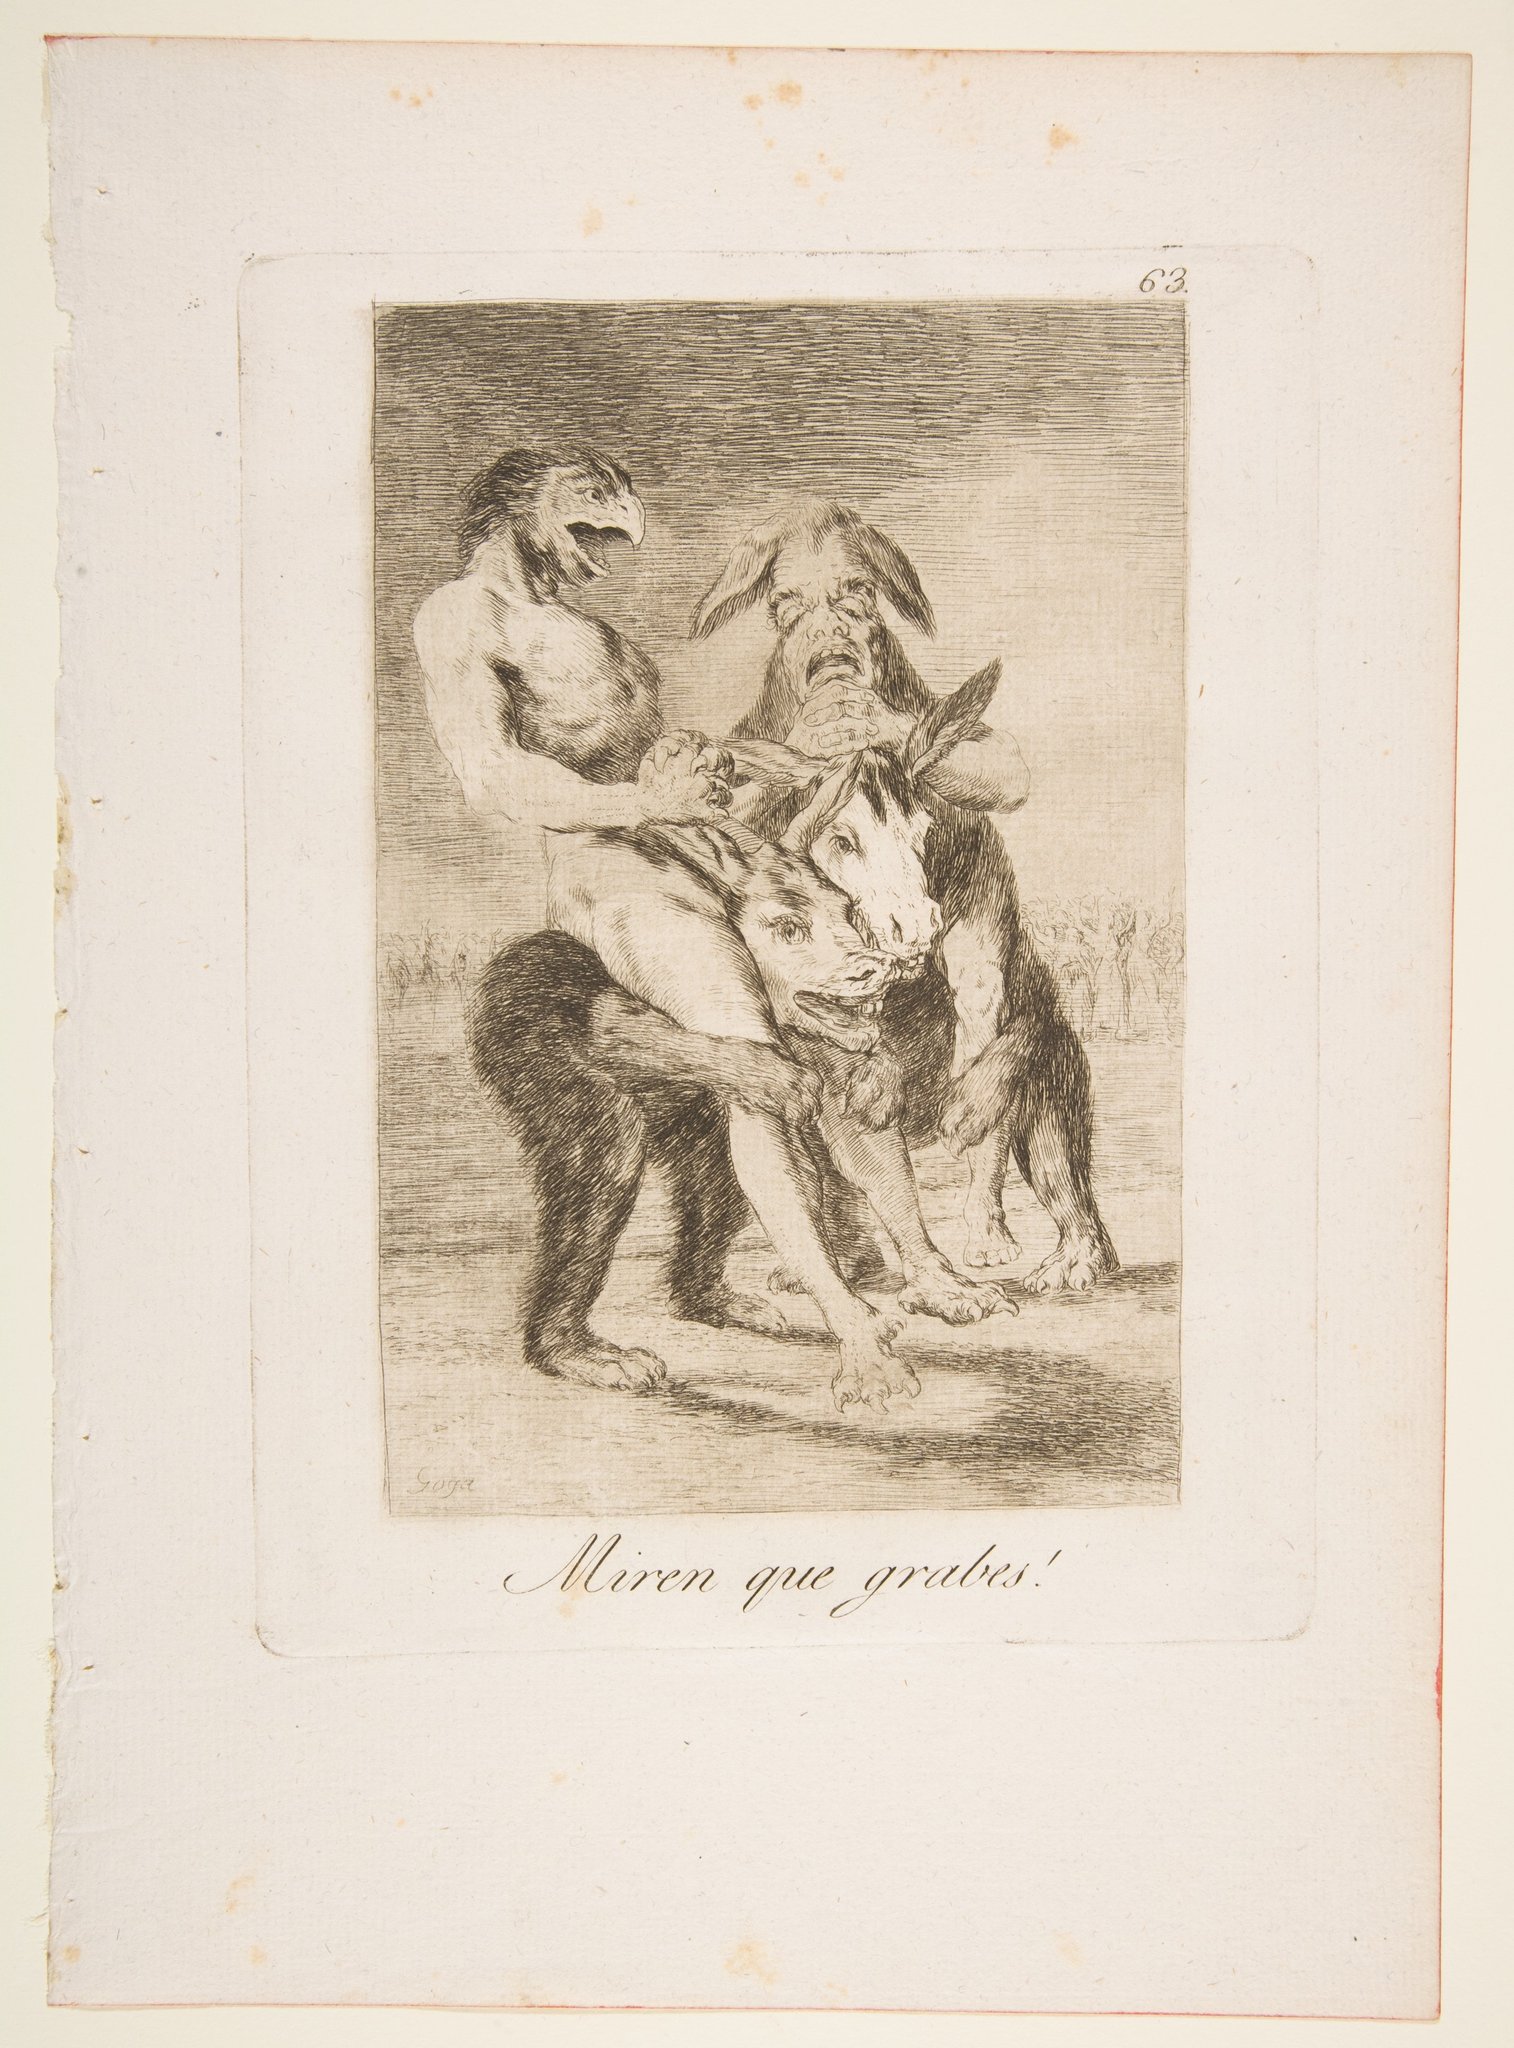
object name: print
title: Plate 63 from "Los Caprichos": Look how solemn they are! (Miren que grabes!)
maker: goya (francisco de goya y lucientes)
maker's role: artist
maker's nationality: spanish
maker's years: 1746-1828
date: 1799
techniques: aquatint, drypoint, etching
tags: donkeys